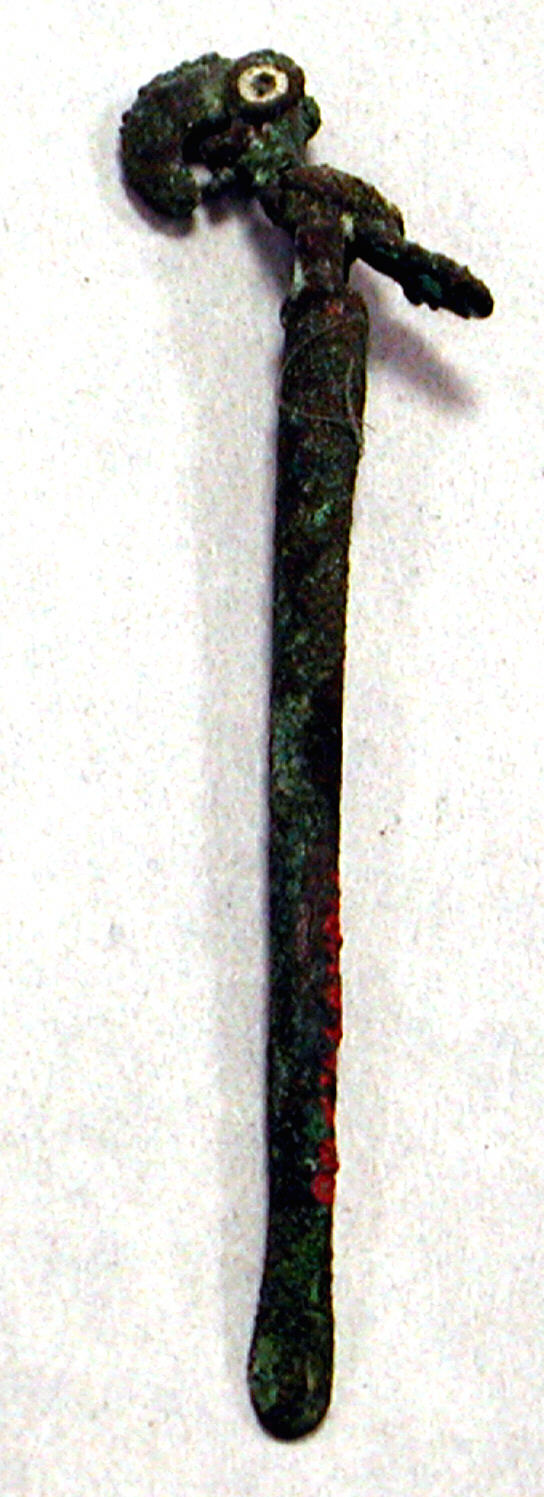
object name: lime spoon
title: Copper Lime Spoon with Bird Top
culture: inca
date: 1401-1600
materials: copper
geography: peru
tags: birds